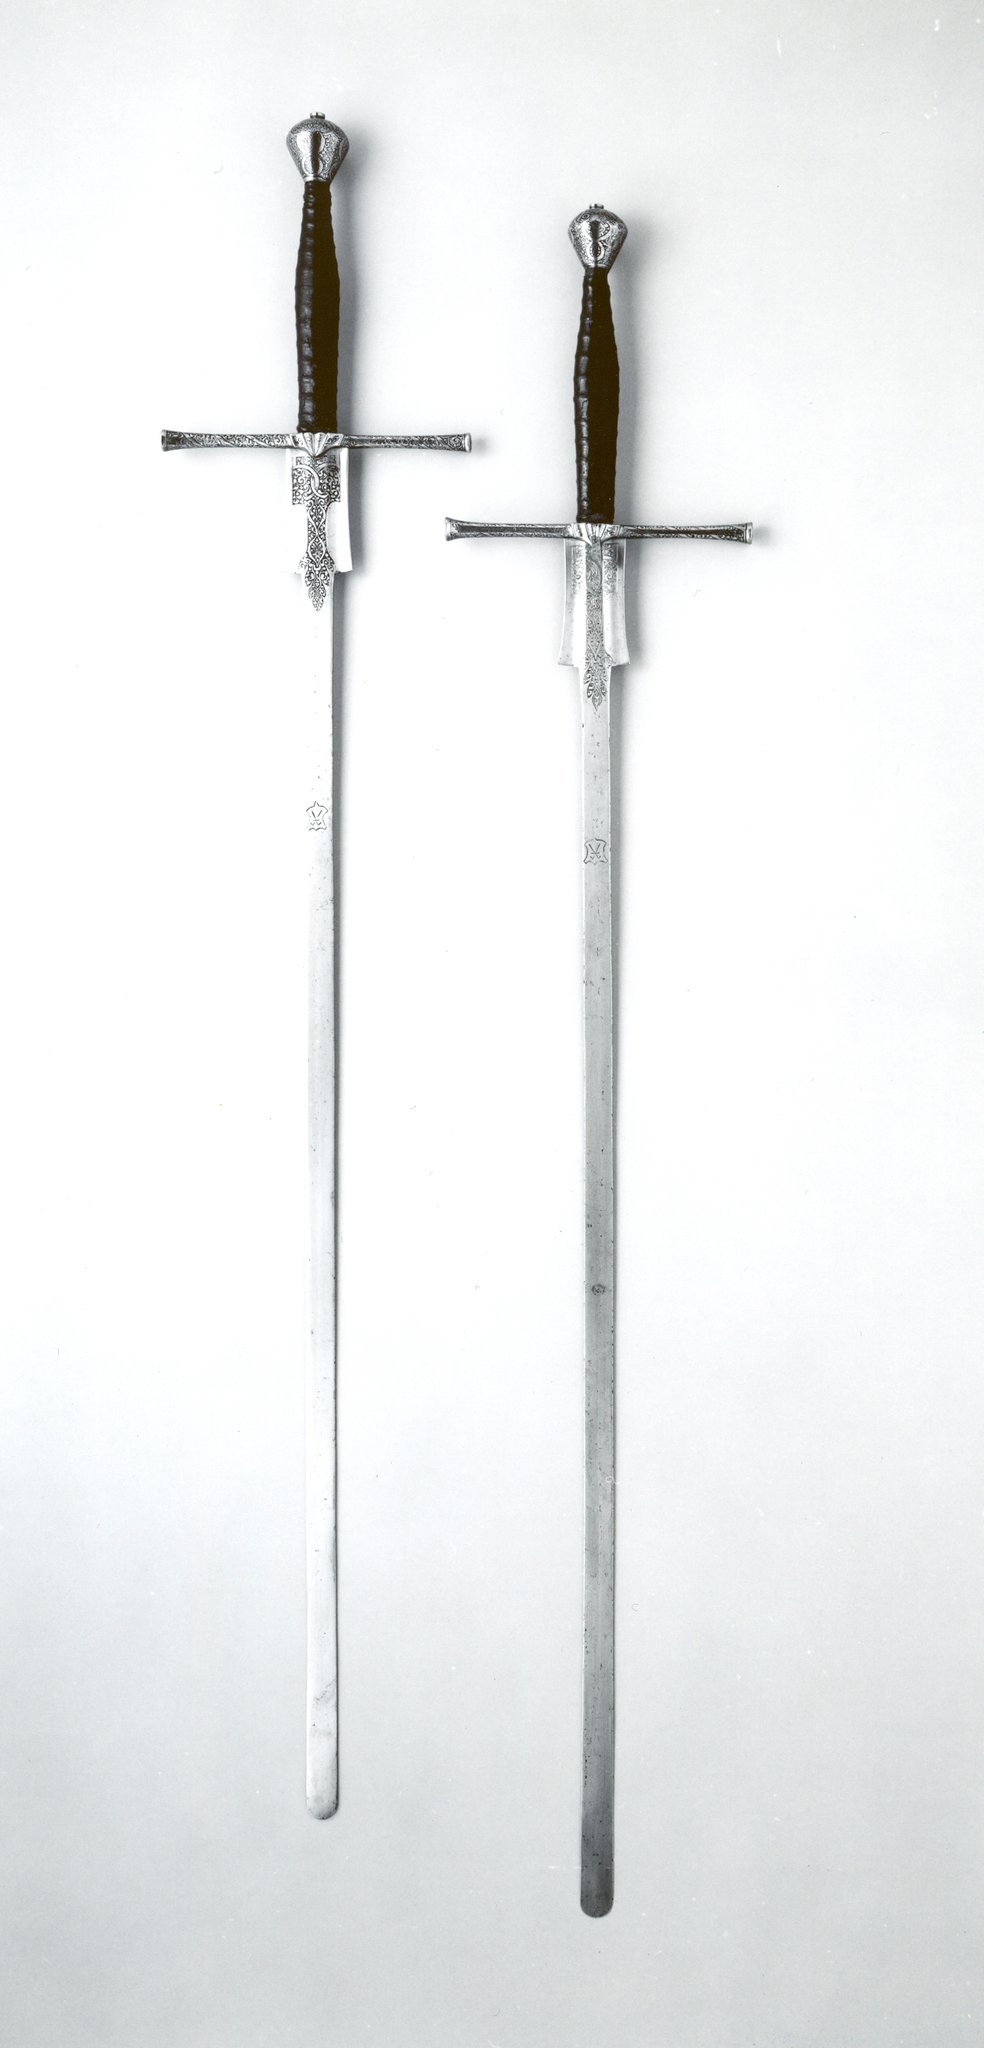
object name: pair of practice sword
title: Pair of Practice Swords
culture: german, saxon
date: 1575-1625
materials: brass, leather, steel, wood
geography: germany